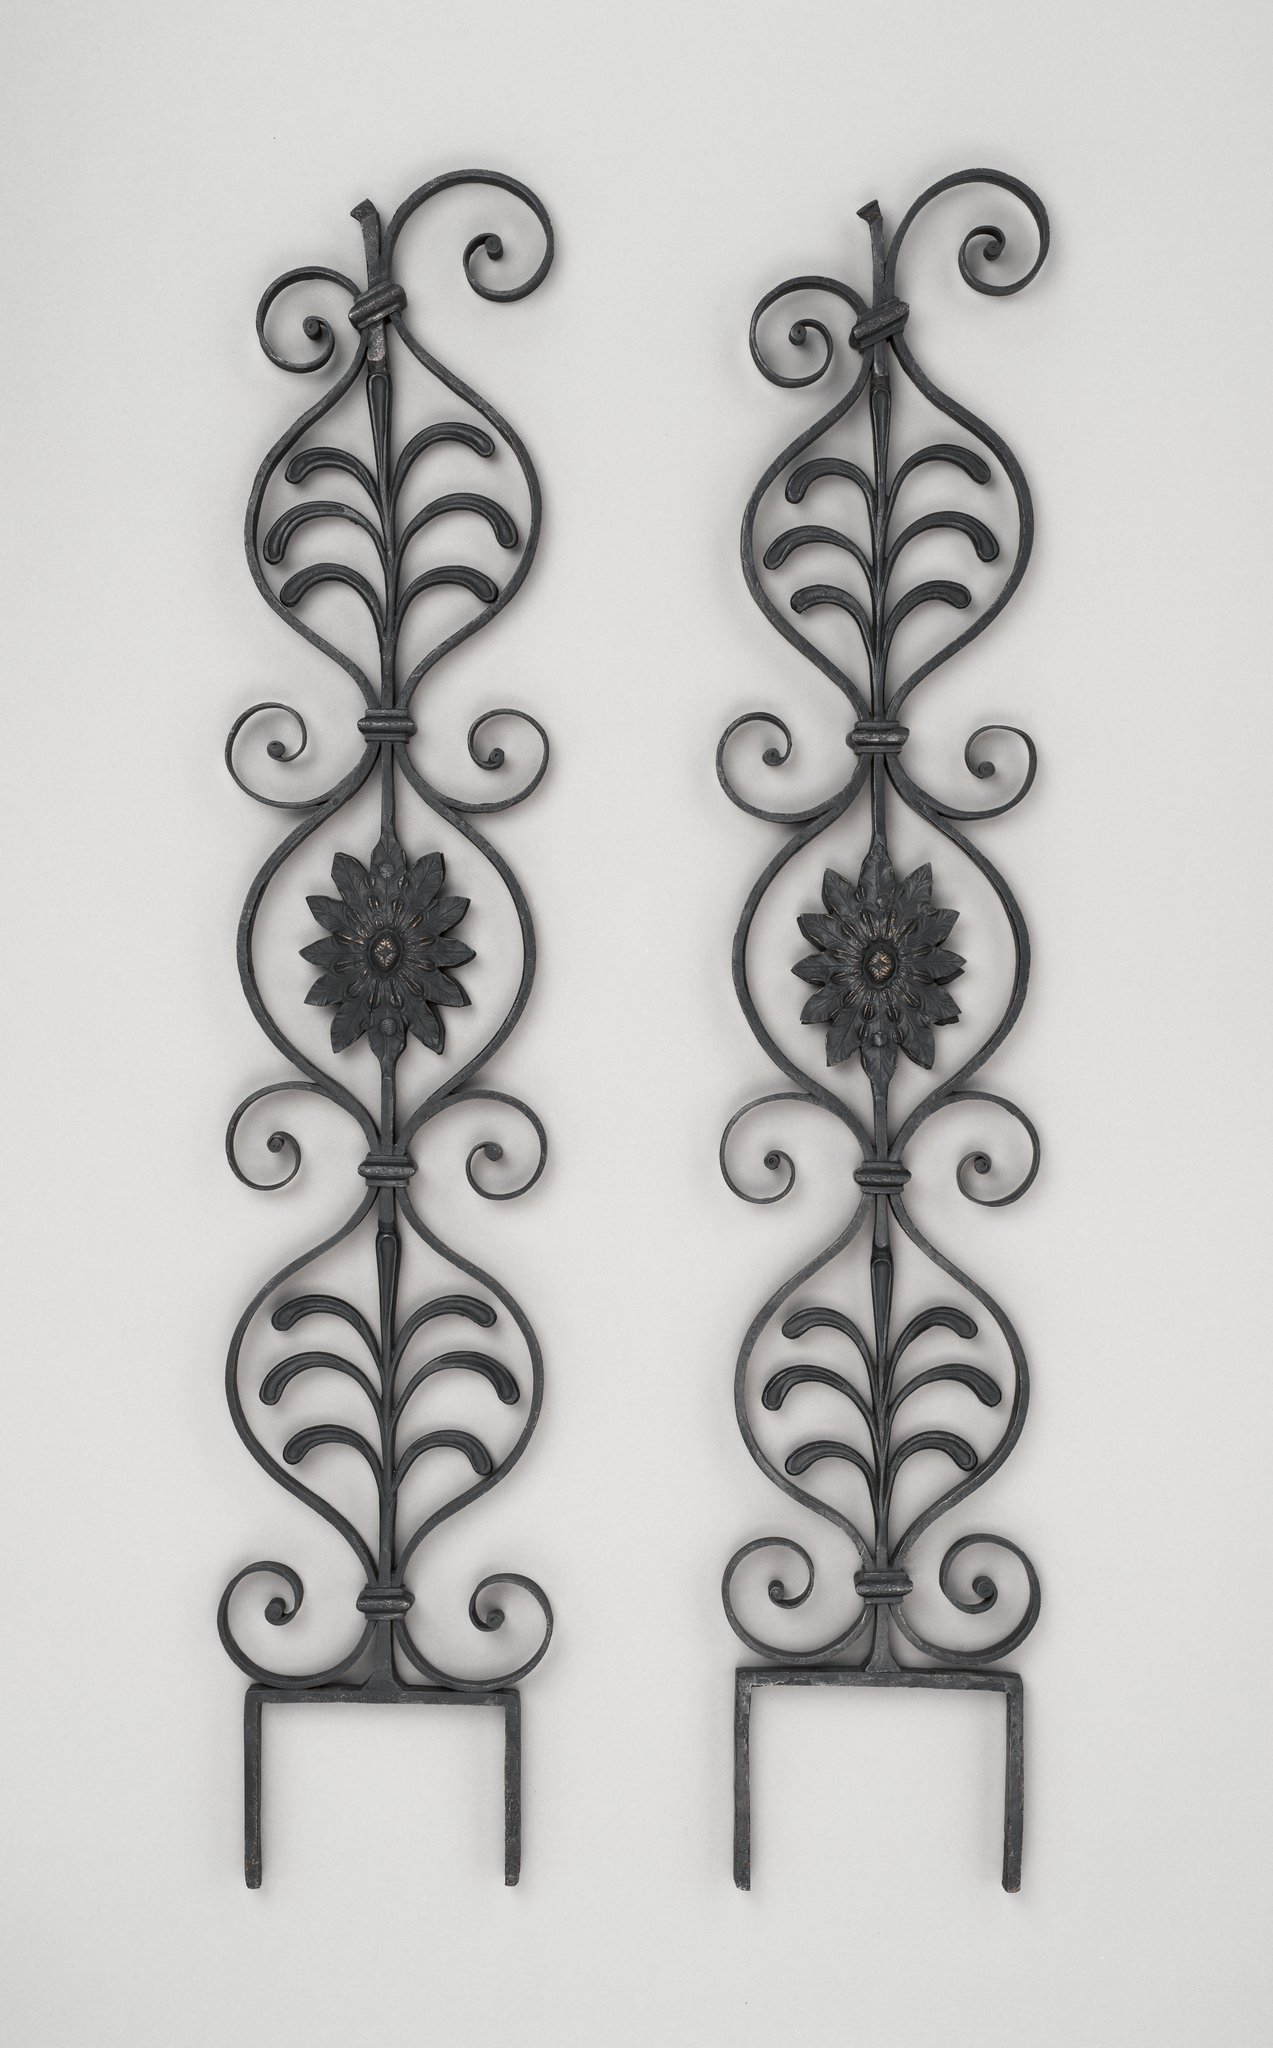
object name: baluster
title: Iron baluster (one of a pair)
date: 1770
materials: brass, iron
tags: flowers